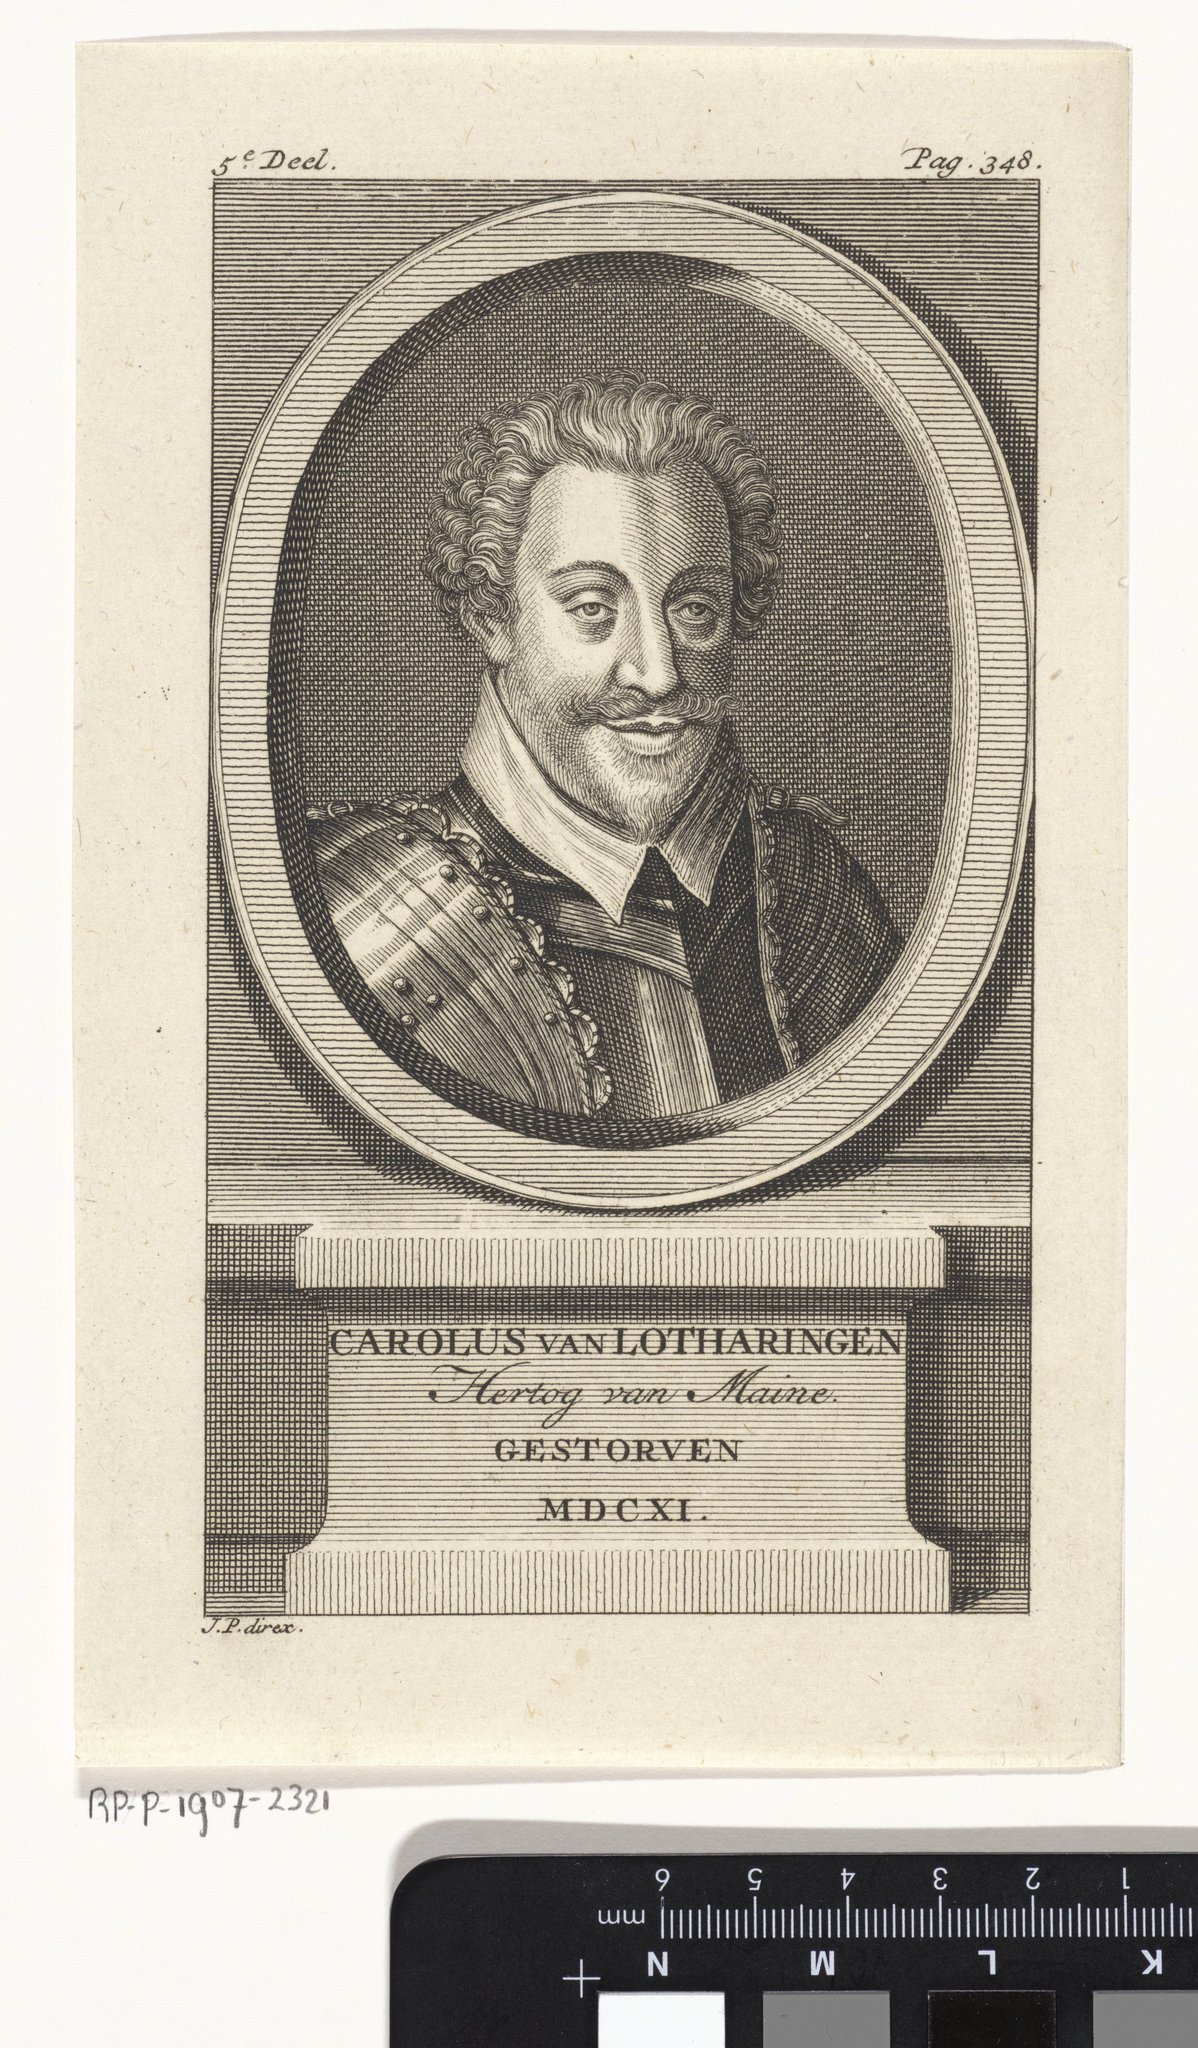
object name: print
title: Portret van Karel van Lotharingen, hertog van Maine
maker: jan punt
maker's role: draughtsman, print maker, publisher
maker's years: 1711-1779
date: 1752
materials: paper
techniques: engraving, etching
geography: northern netherlands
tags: armour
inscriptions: collector's mark: Lugt 2228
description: Illustratie uit: Meteren, Emanuel van. Historie van de oorlogen en geschiedenissen der Nederlanderen, en der zelver naburen: beginnende met den jare 1315, en eindigende met den jare 1611, deel V, p. 348. Gorinchem: weduwe Nicolaas Goetzee, 1752.